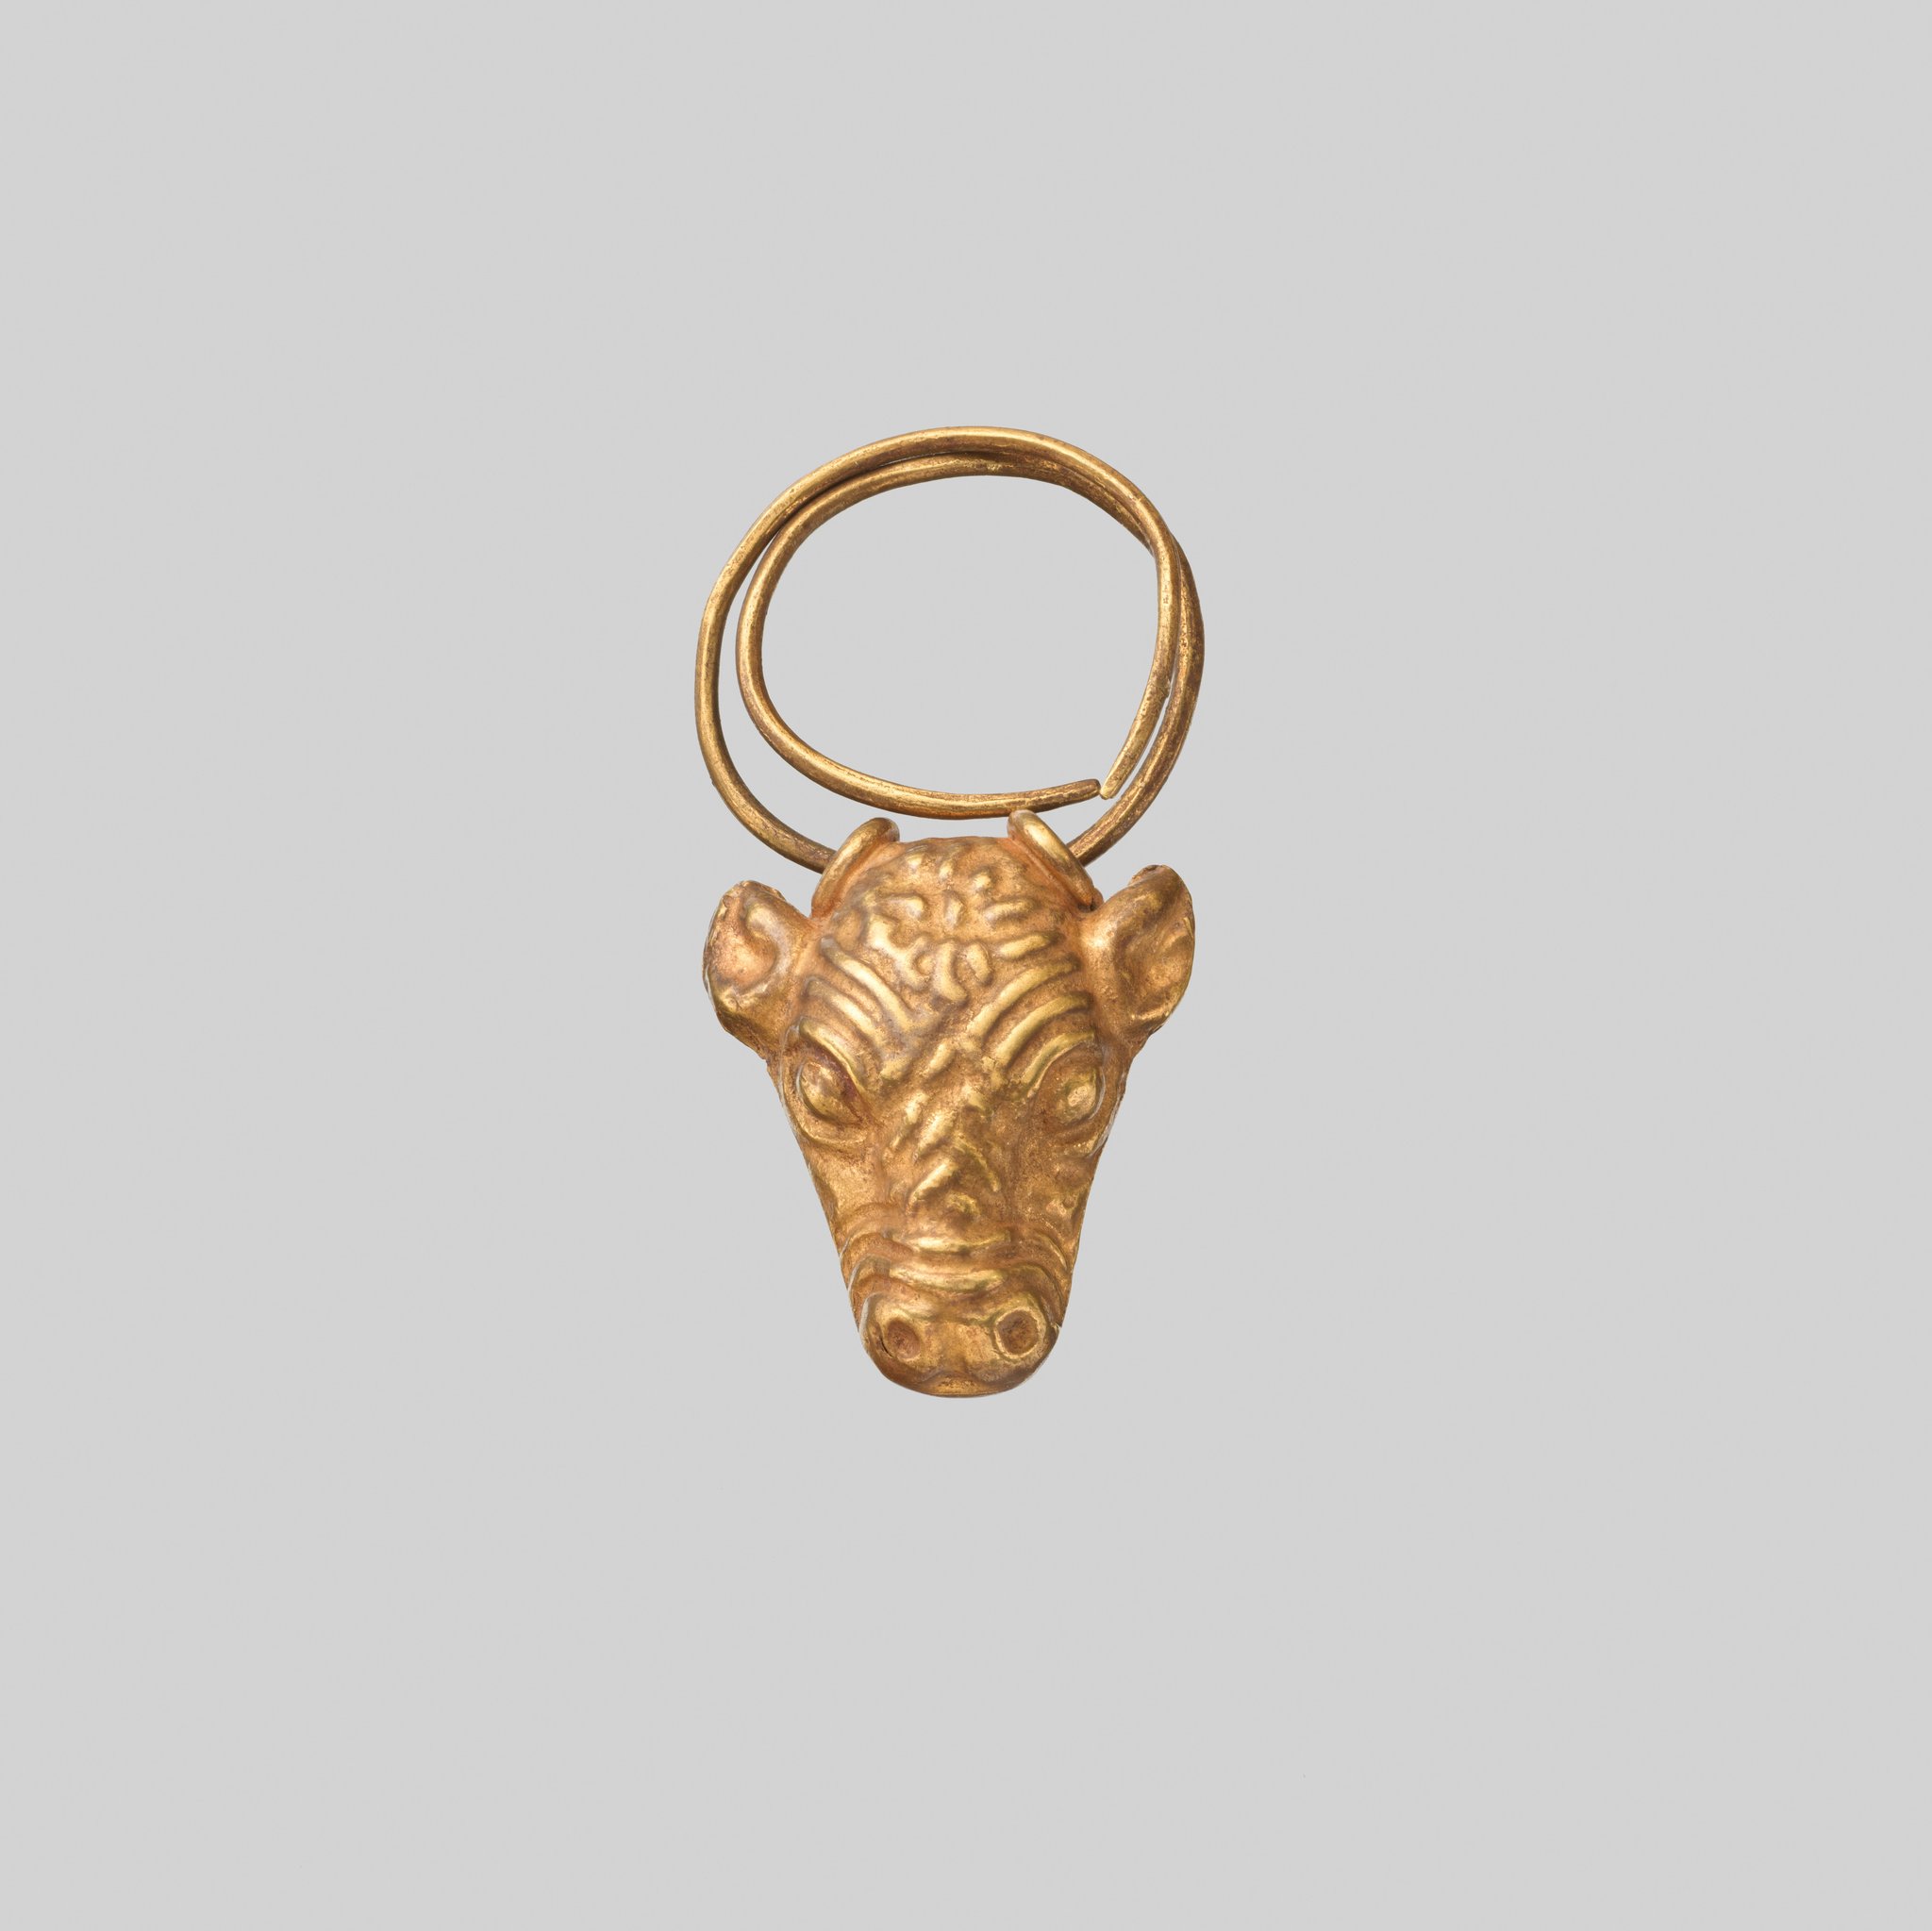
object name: earring with head of bull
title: Gold earring with head of a bull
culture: cypriot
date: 1400-1050 BCE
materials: gold